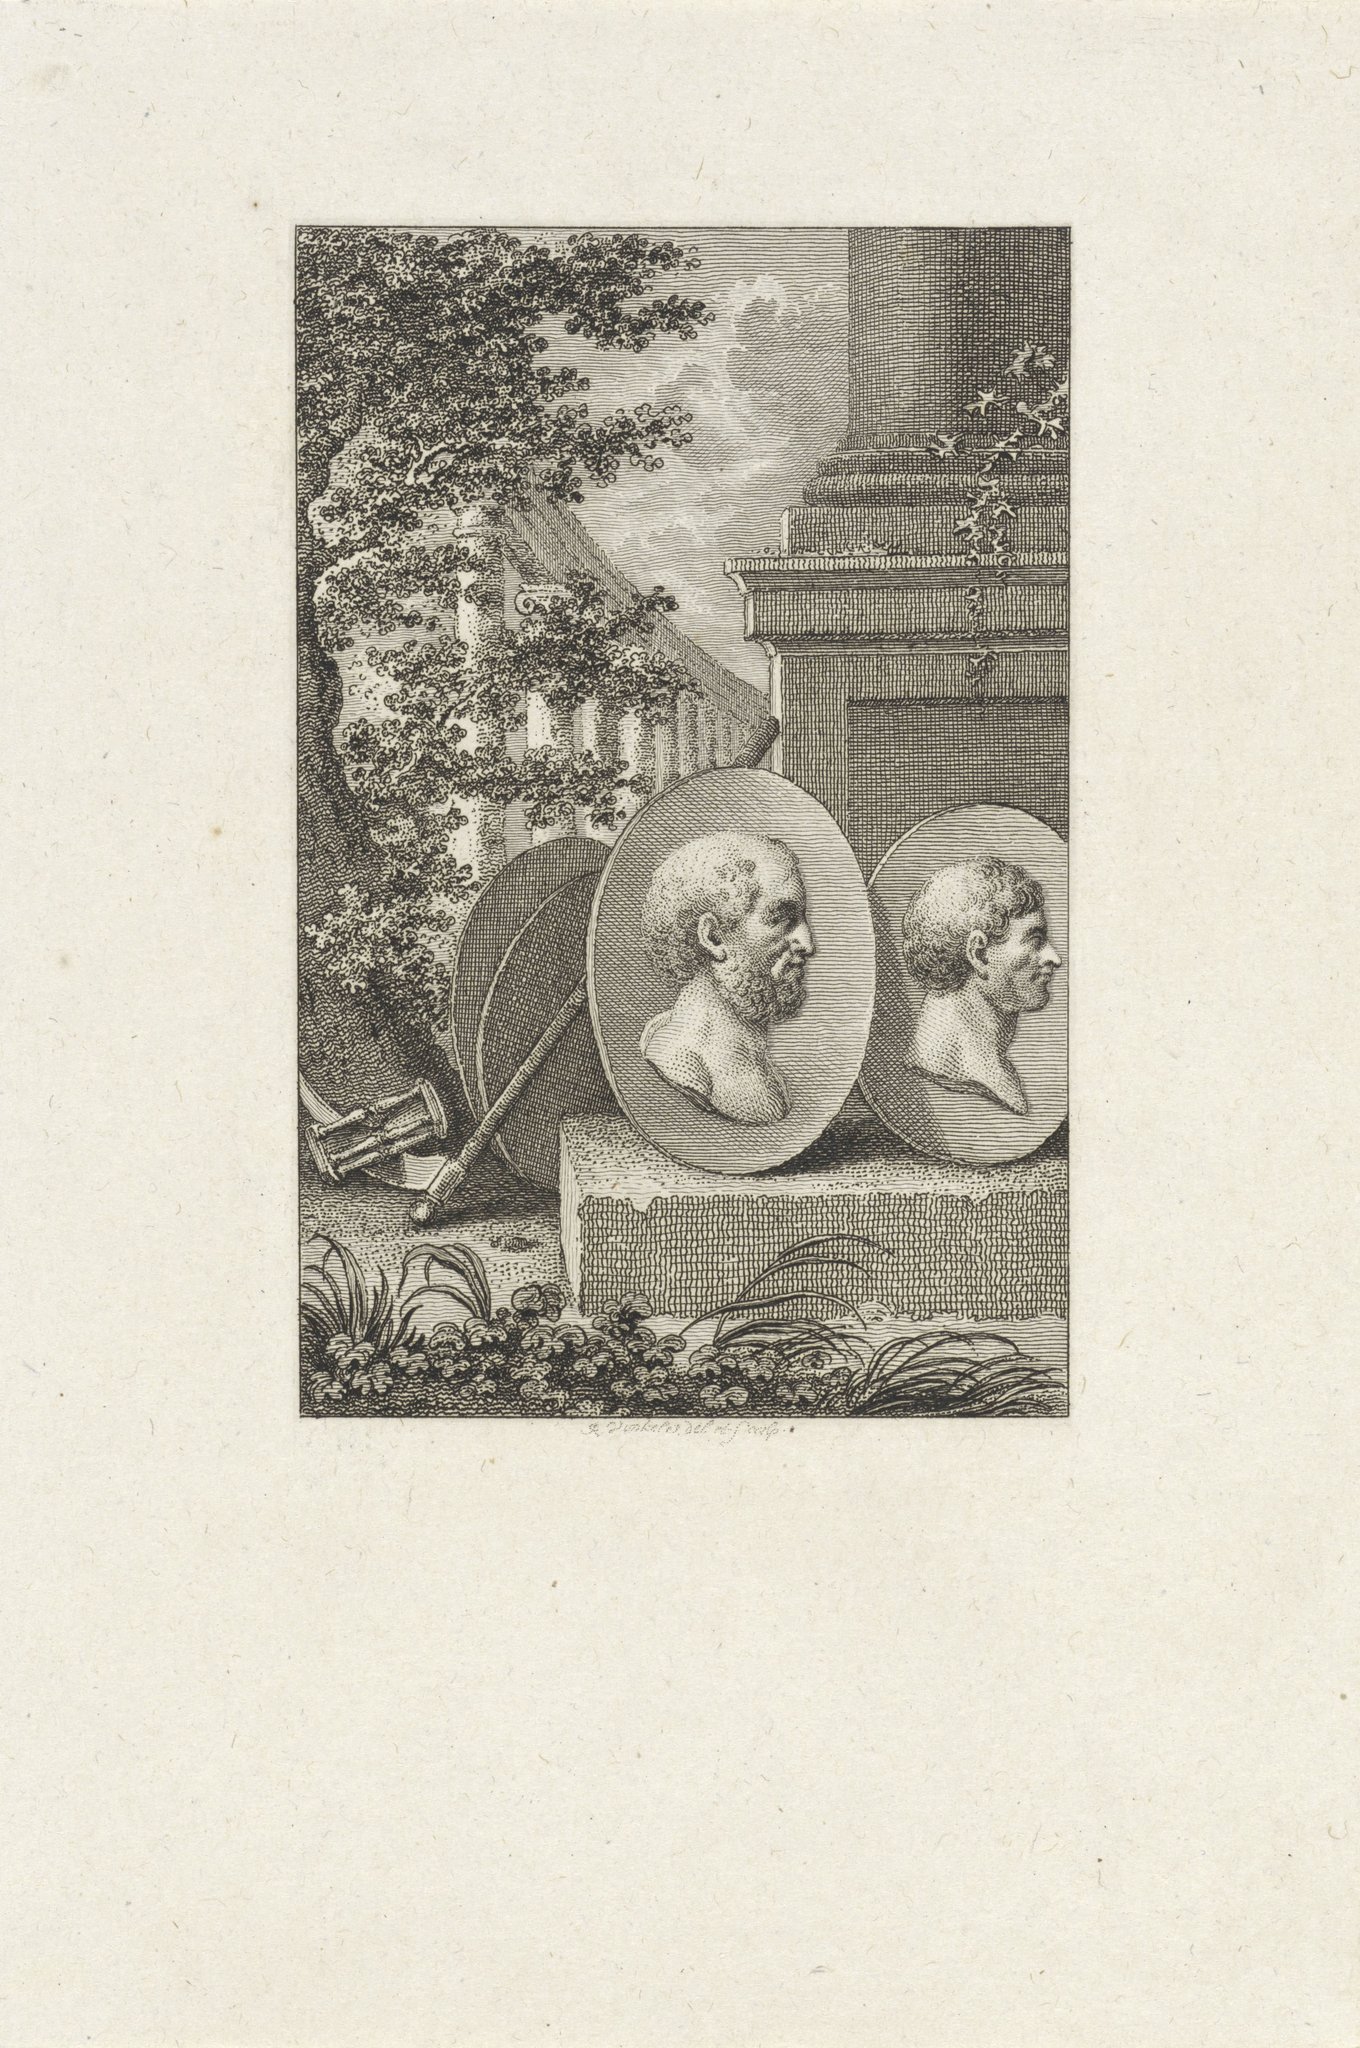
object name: print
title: Medaillons met portretten van Aratos van Sikyon en Marcus Brutus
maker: reinier vinkeles (i)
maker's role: draughtsman, print maker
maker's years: 1741-1816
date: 1789-1809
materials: paper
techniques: etching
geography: amsterdam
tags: (story of) marcus junius brutus, column, pillar ~ architecture, other allegories of time, e.g. 'tempo' (ripa)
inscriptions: collector's mark: Lugt 240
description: Latere staat prent ook gebruikt als boekillustratie in: Plutarchus [bewerkt door E. Wassenbergh en H. Bosscha]. De levens van doorluchtige Grieken en Romeinen, onderling vergeleeken (...). 12 dln. Amsterdam: Johannes Allart, 1789-1809.